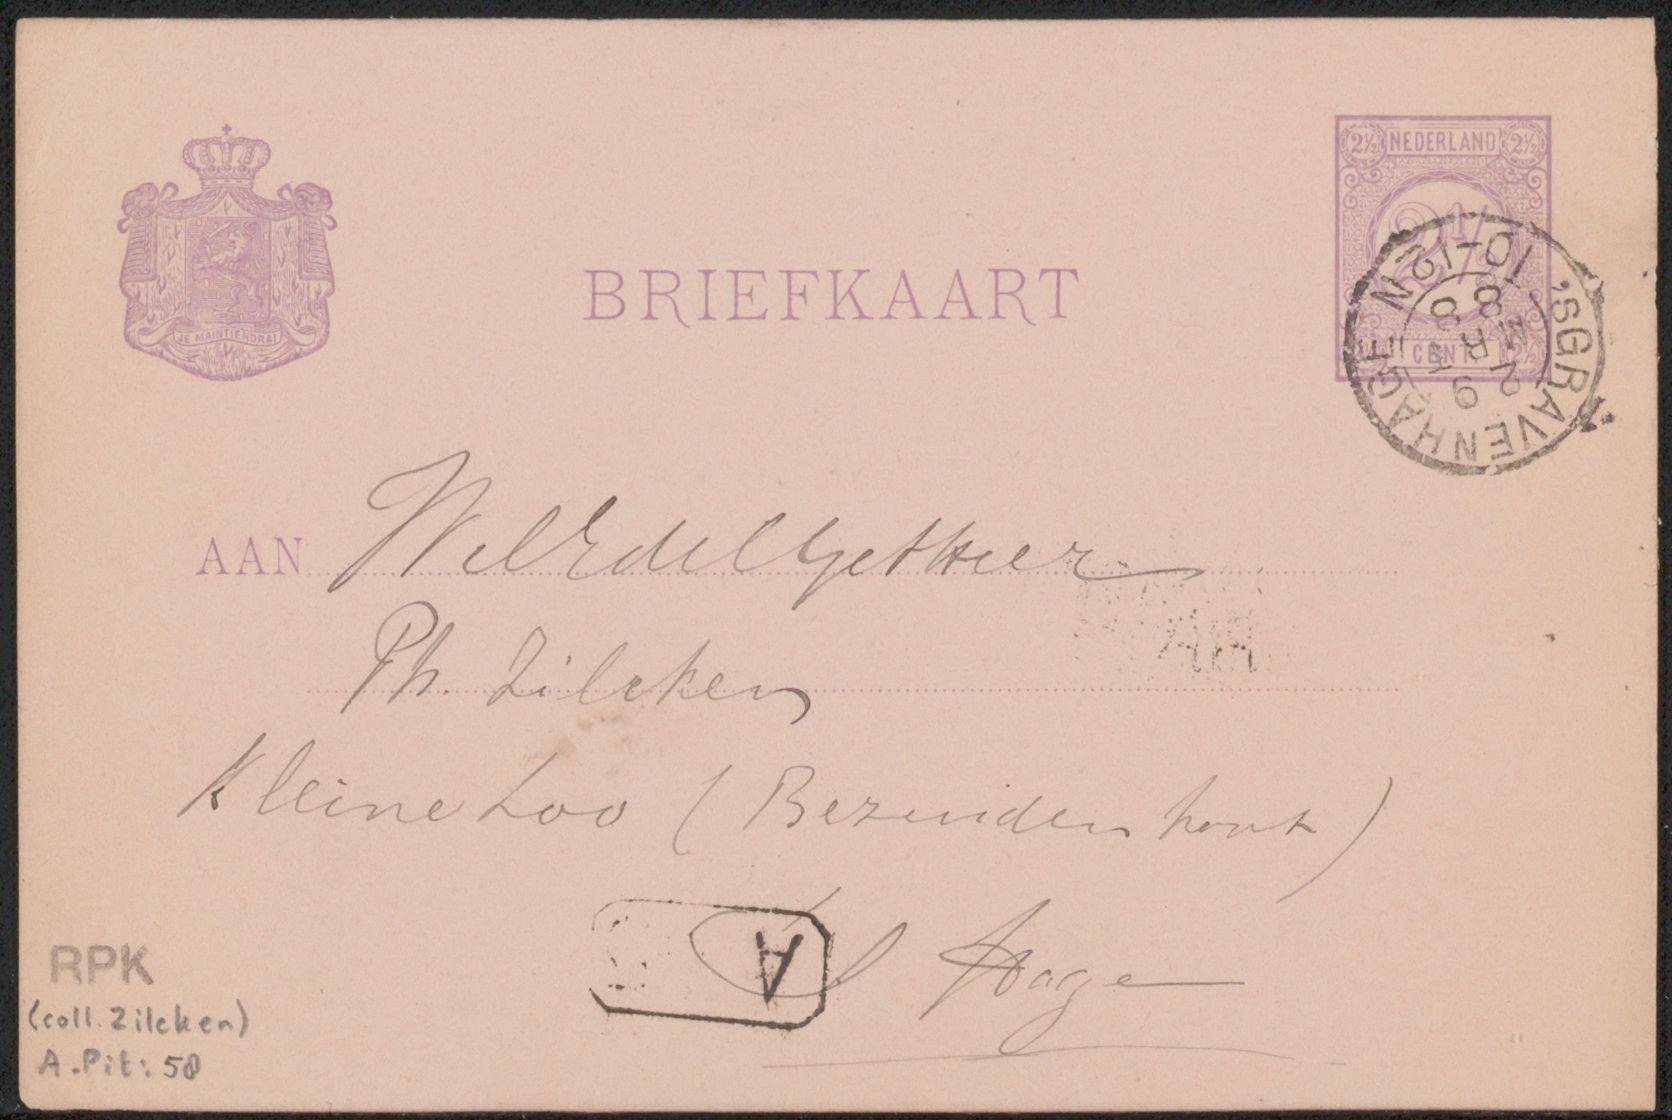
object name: postcard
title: Briefkaart aan Philip Zilcken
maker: adriaan pit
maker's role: print maker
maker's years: 1860-1944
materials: cardboard, ink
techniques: pen, writing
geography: the hague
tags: draughtsman, philip zilcken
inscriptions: collector's mark: ‘RPK’